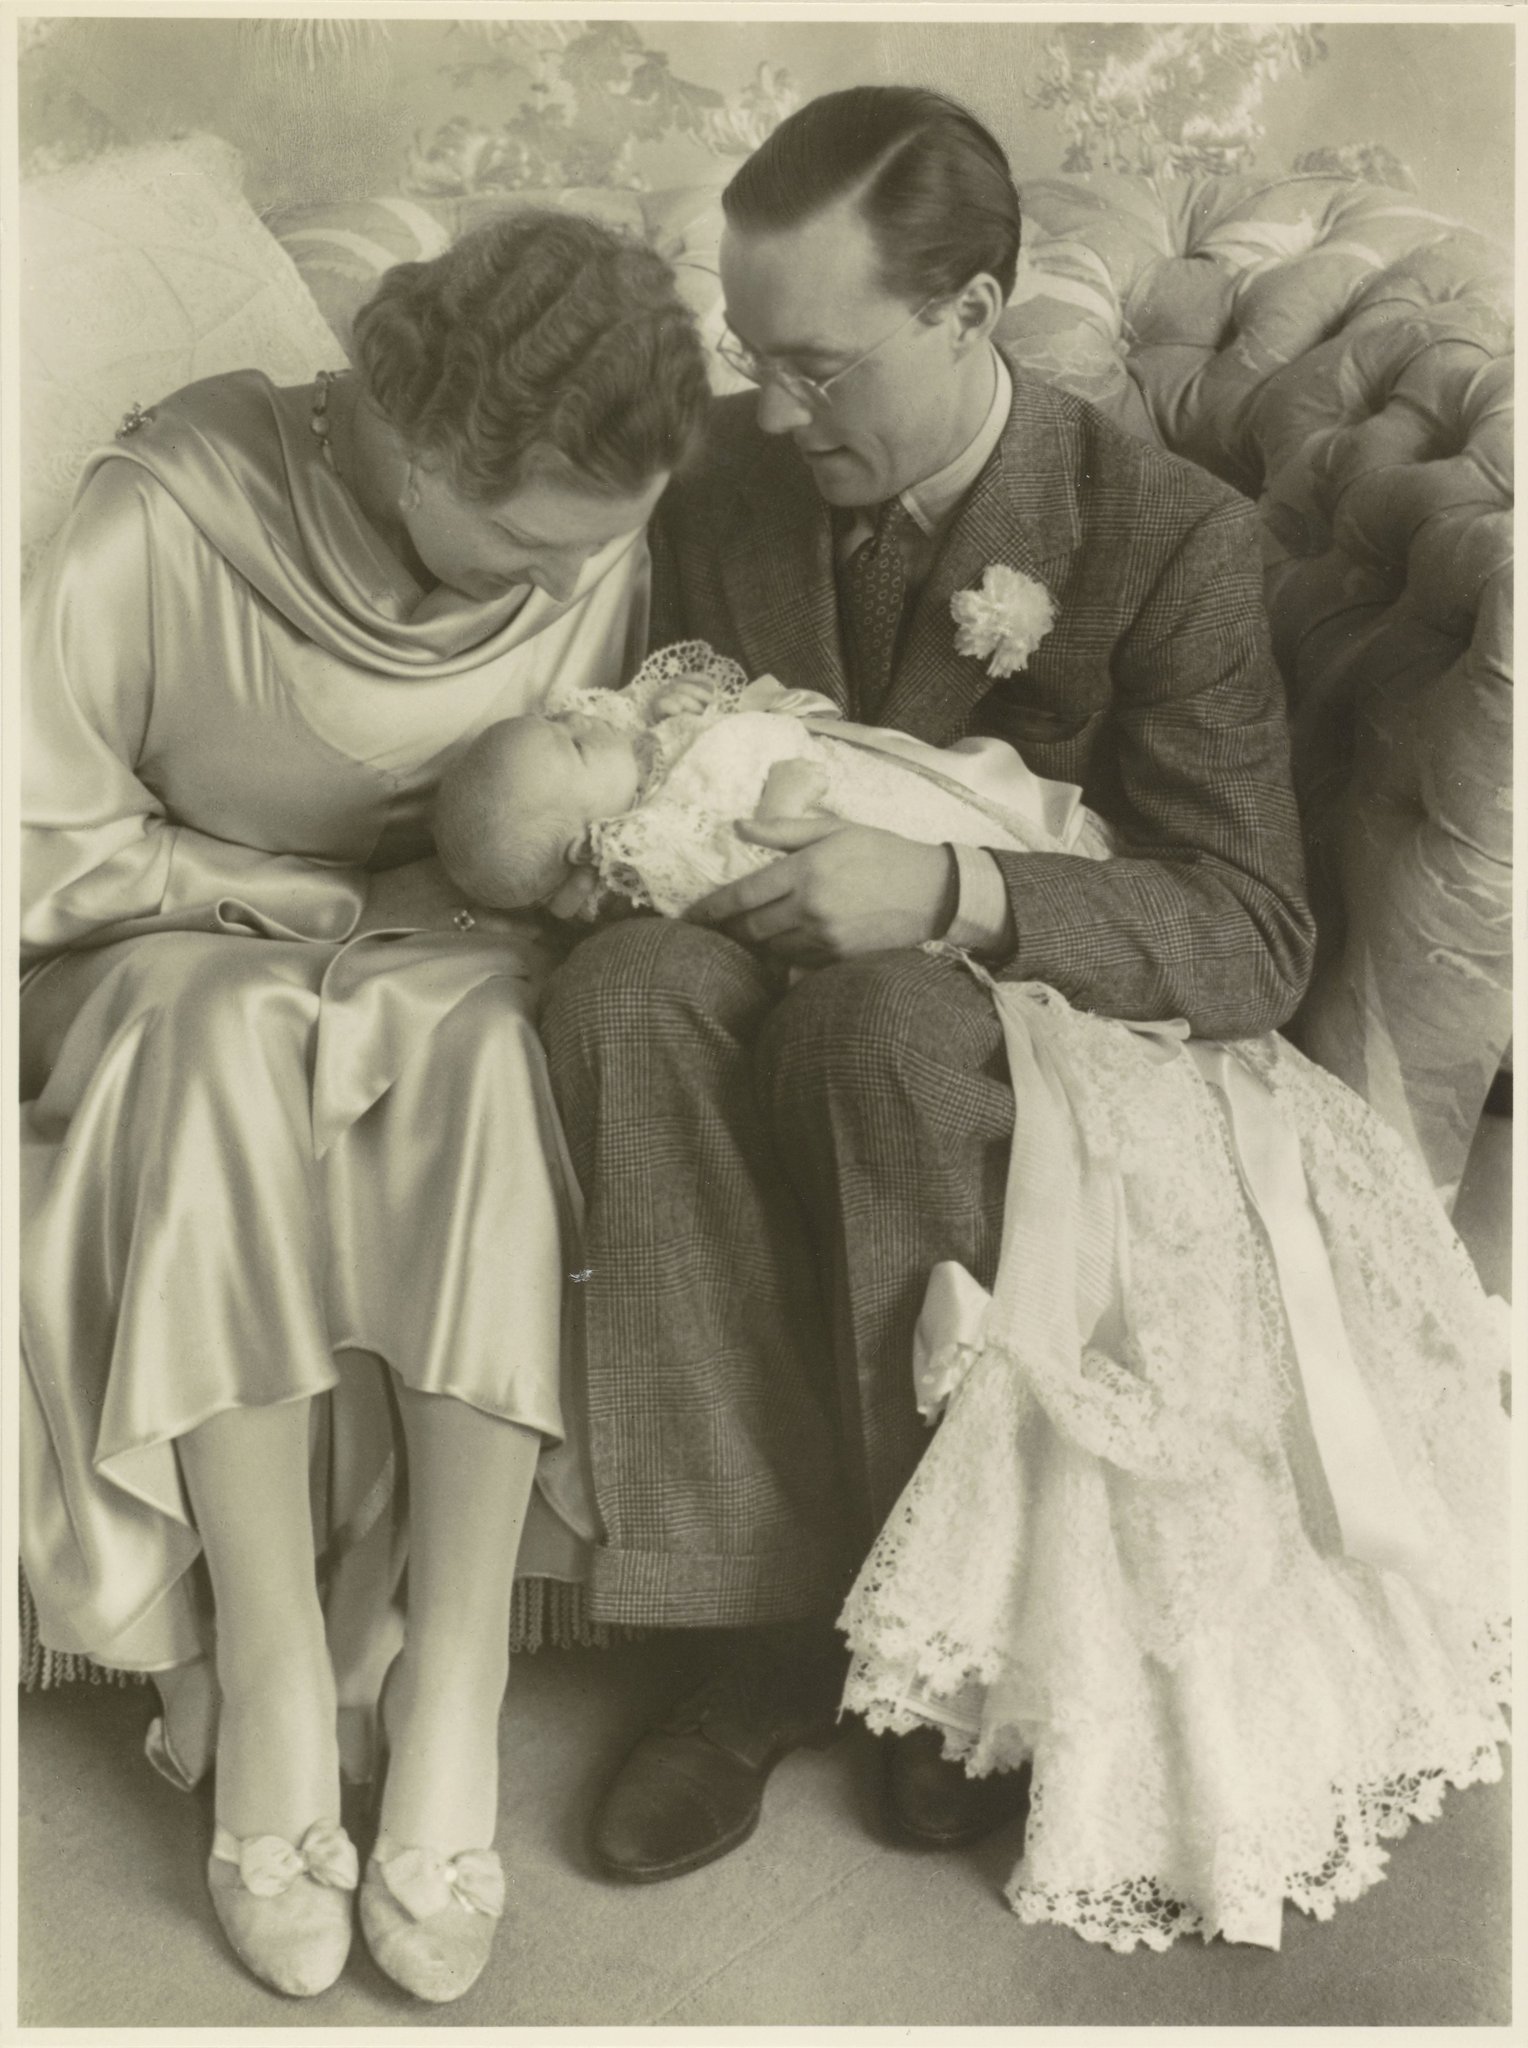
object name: photograph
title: Portret van Juliana, koningin der Nederlanden, Bernhard van Lippe-Biesterfeld en Beatrix, koningin der Nederlanden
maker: Anonymous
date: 1938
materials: photographic support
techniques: photography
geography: netherlands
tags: utrecht, bernhard (prins der nederlanden), beatrix (koningin der nederlanden), the hague, juliana of the netherlands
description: De hier vermelde titel verwijst naar de hoogst verkregen titel van de geportretteerde, niet per se naar de titel die de geportretteerde op deze voorstelling draagt.